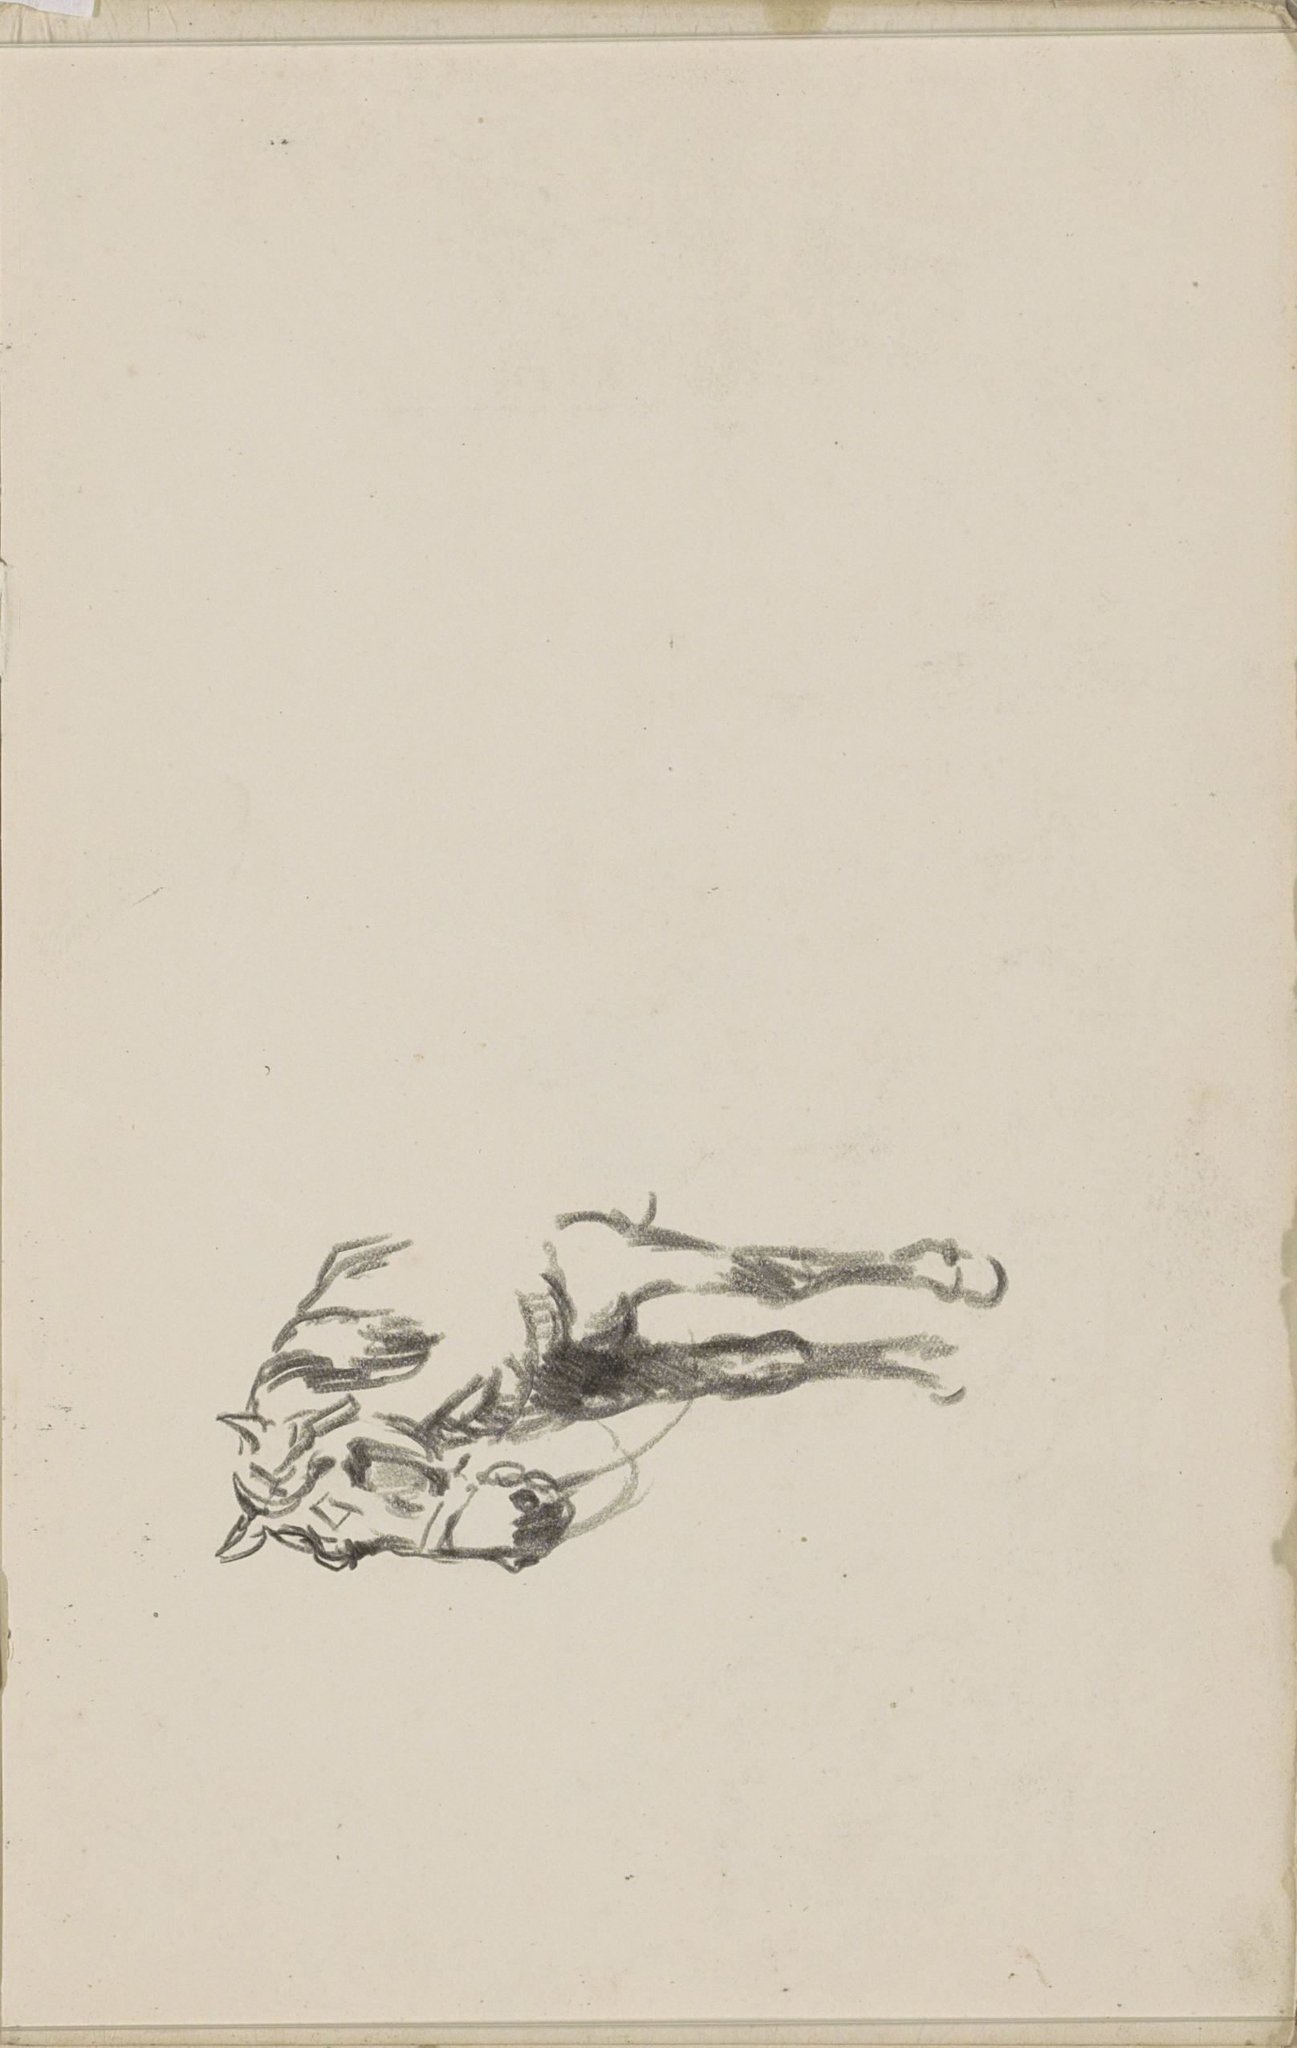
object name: sketchbook leaf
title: Paard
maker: cornelis vreedenburgh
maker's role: draughtsman, print maker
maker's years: 1880-1946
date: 1890-1946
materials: chalk, paper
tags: horse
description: Blad 3 recto uit een schetsboek met 45 bladen.